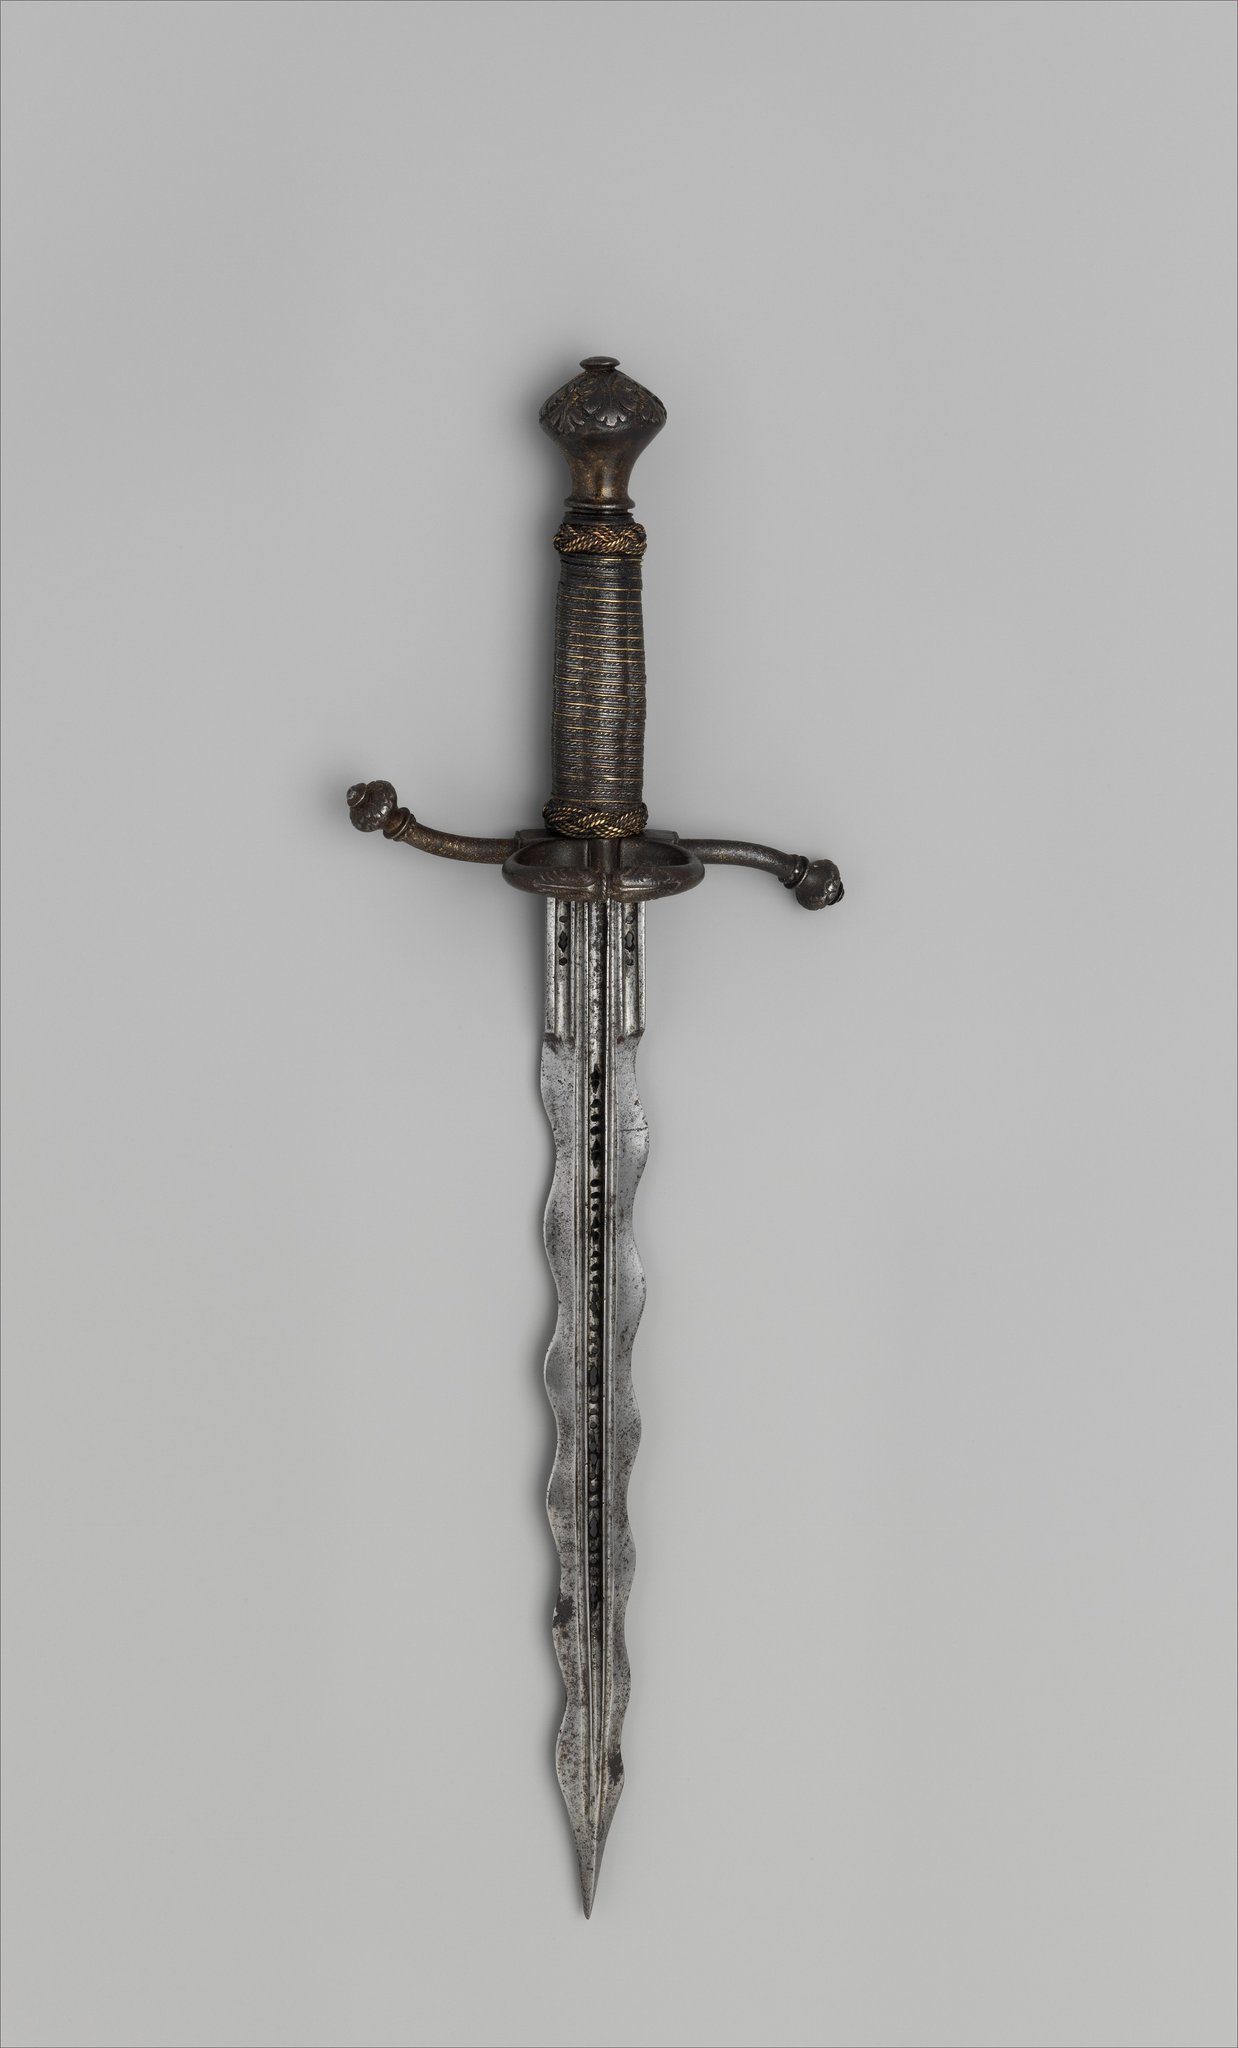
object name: parrying dagger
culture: italian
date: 1550-1575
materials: brass, gold, steel, wood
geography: italy